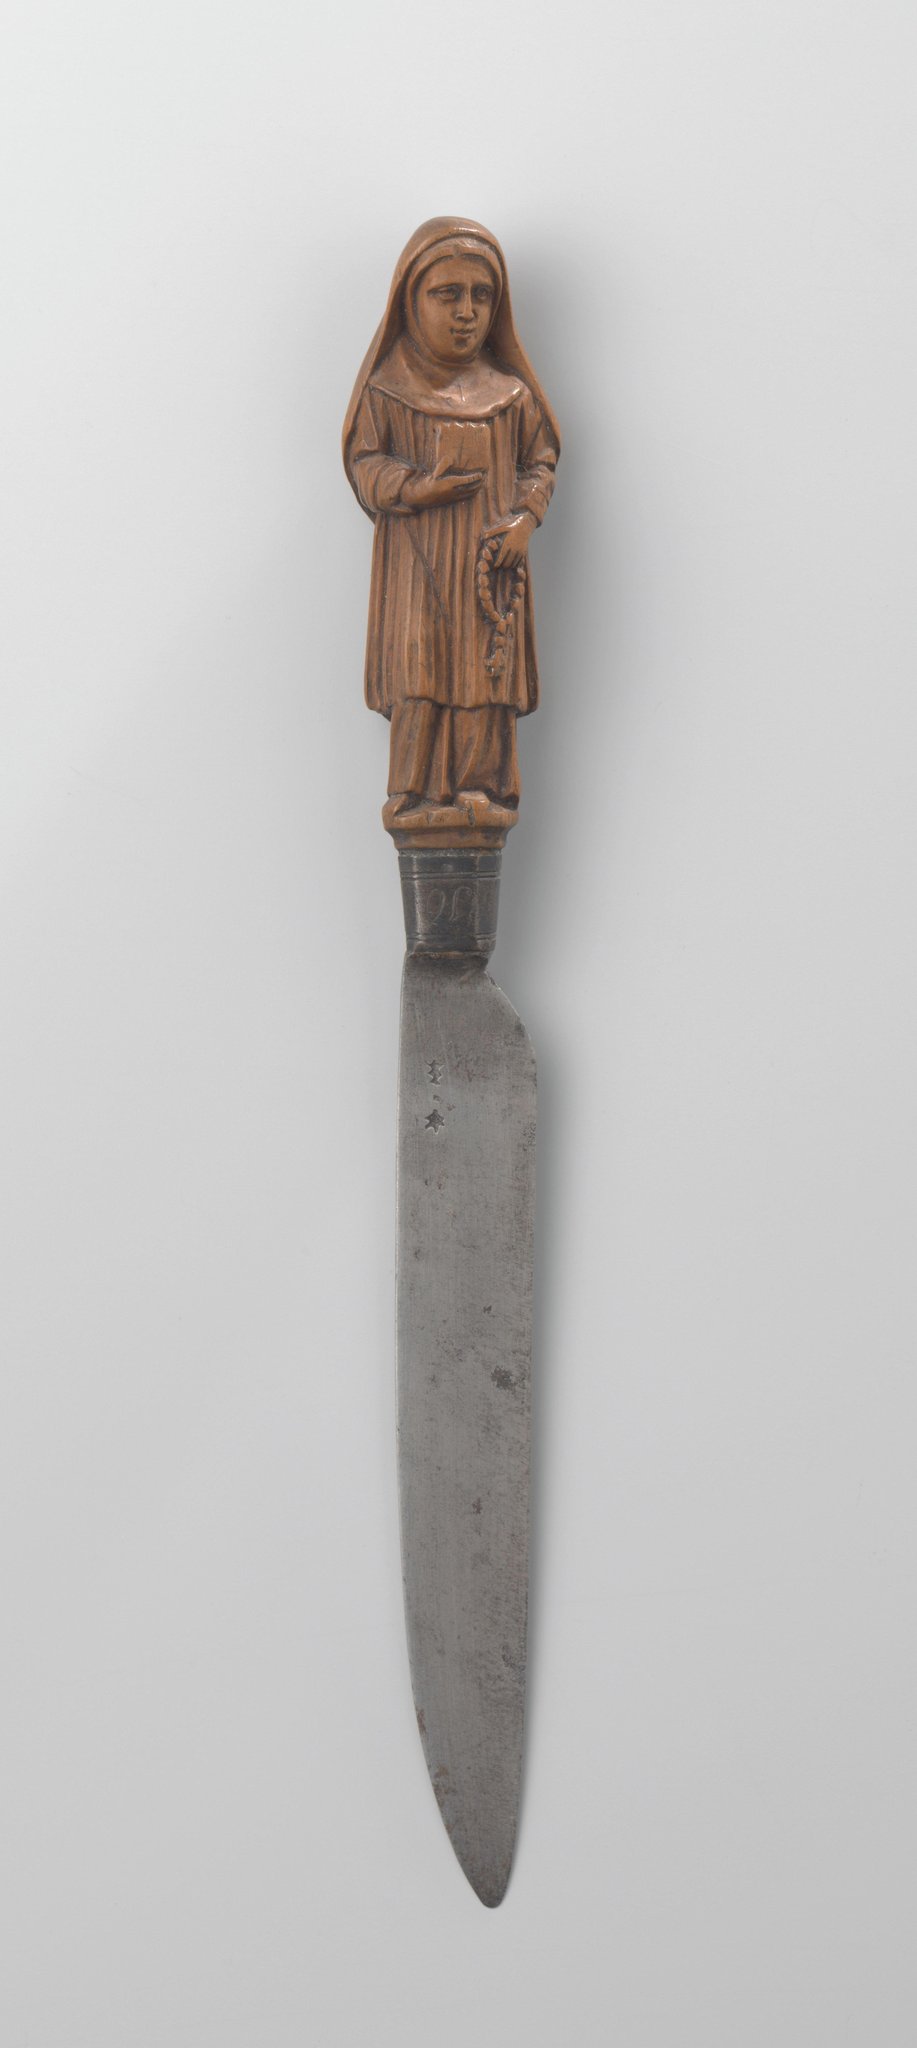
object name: knife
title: Knife with a Handle Representing a Nun with a Book and a Rosary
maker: Anonymous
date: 1650-1700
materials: wood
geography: northern netherlands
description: De non draagt in haar rechter hand een pot